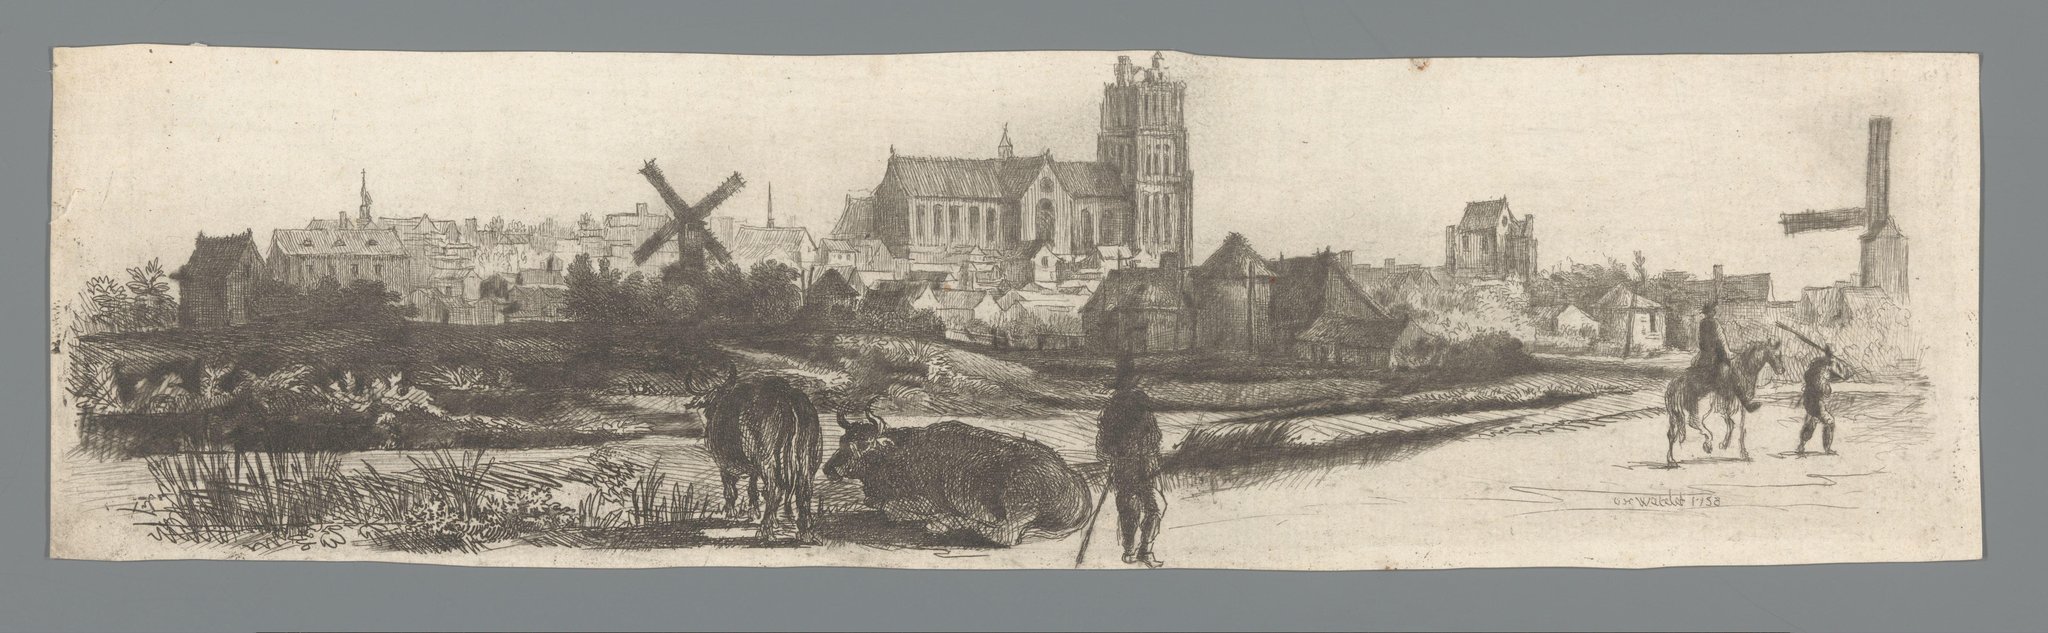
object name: print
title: Landschap met een gezicht op Dordrecht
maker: claude henri watelet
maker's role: print maker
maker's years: 1718-1786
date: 1758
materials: paper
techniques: etching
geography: france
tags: cow, church (exterior), city-view, and landscape with man-made constructions (+ city(-scape) with figures, staffage), dordrecht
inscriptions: collector's mark: Lugt 240